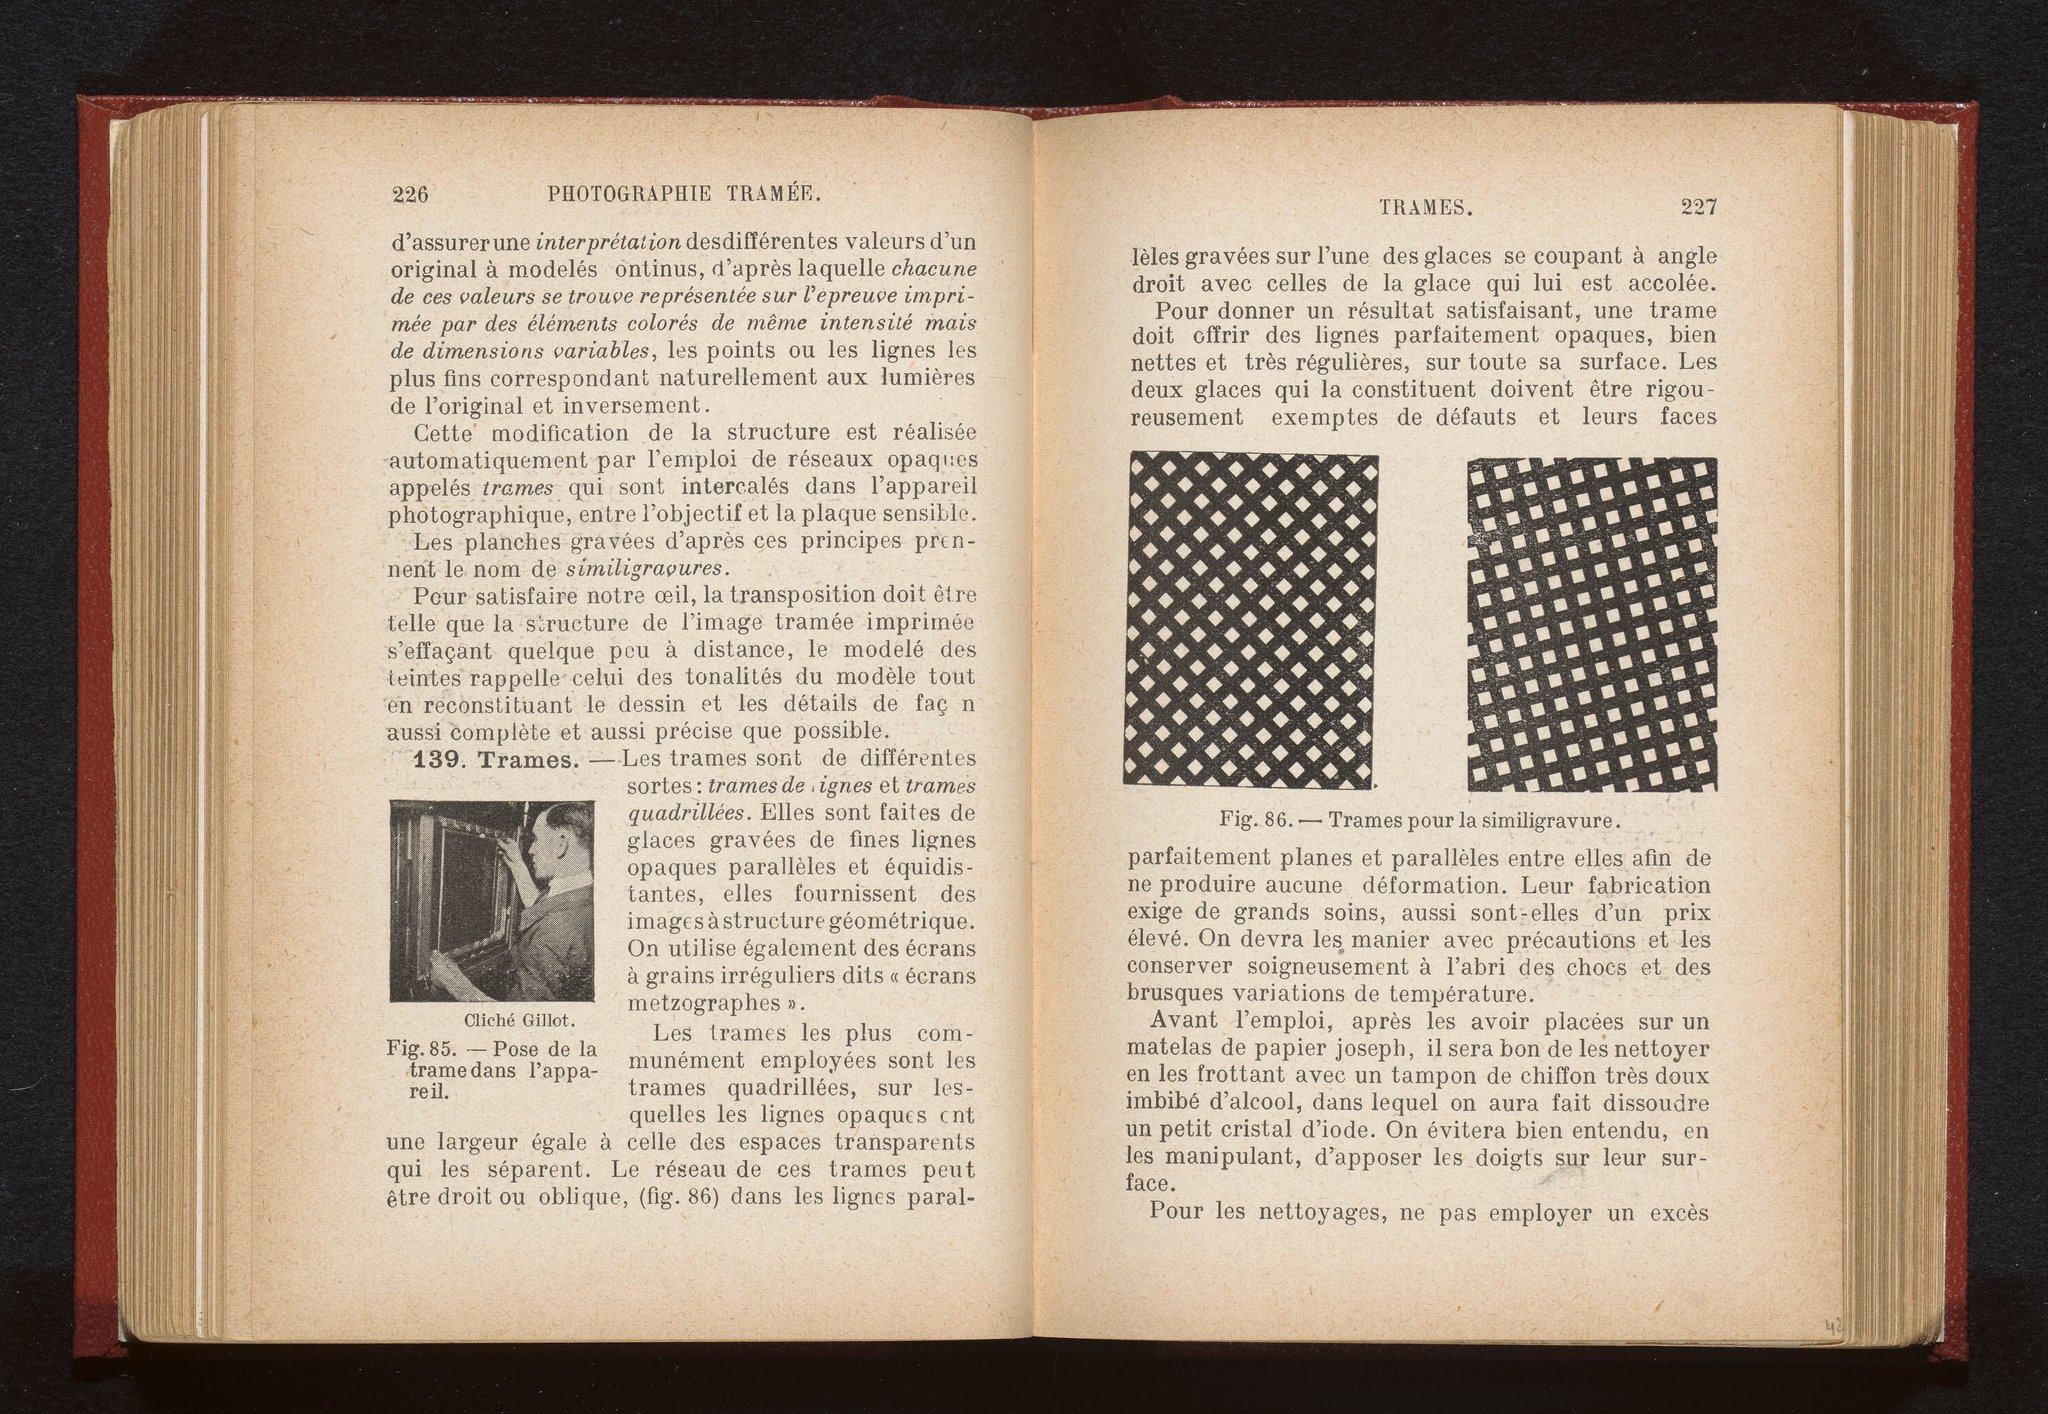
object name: page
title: Pose de la trame dans l'appareil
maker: Anonymous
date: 1922-1932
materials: paper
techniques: autotype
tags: photographic apparatus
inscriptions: number: ‘Fig. 85.’